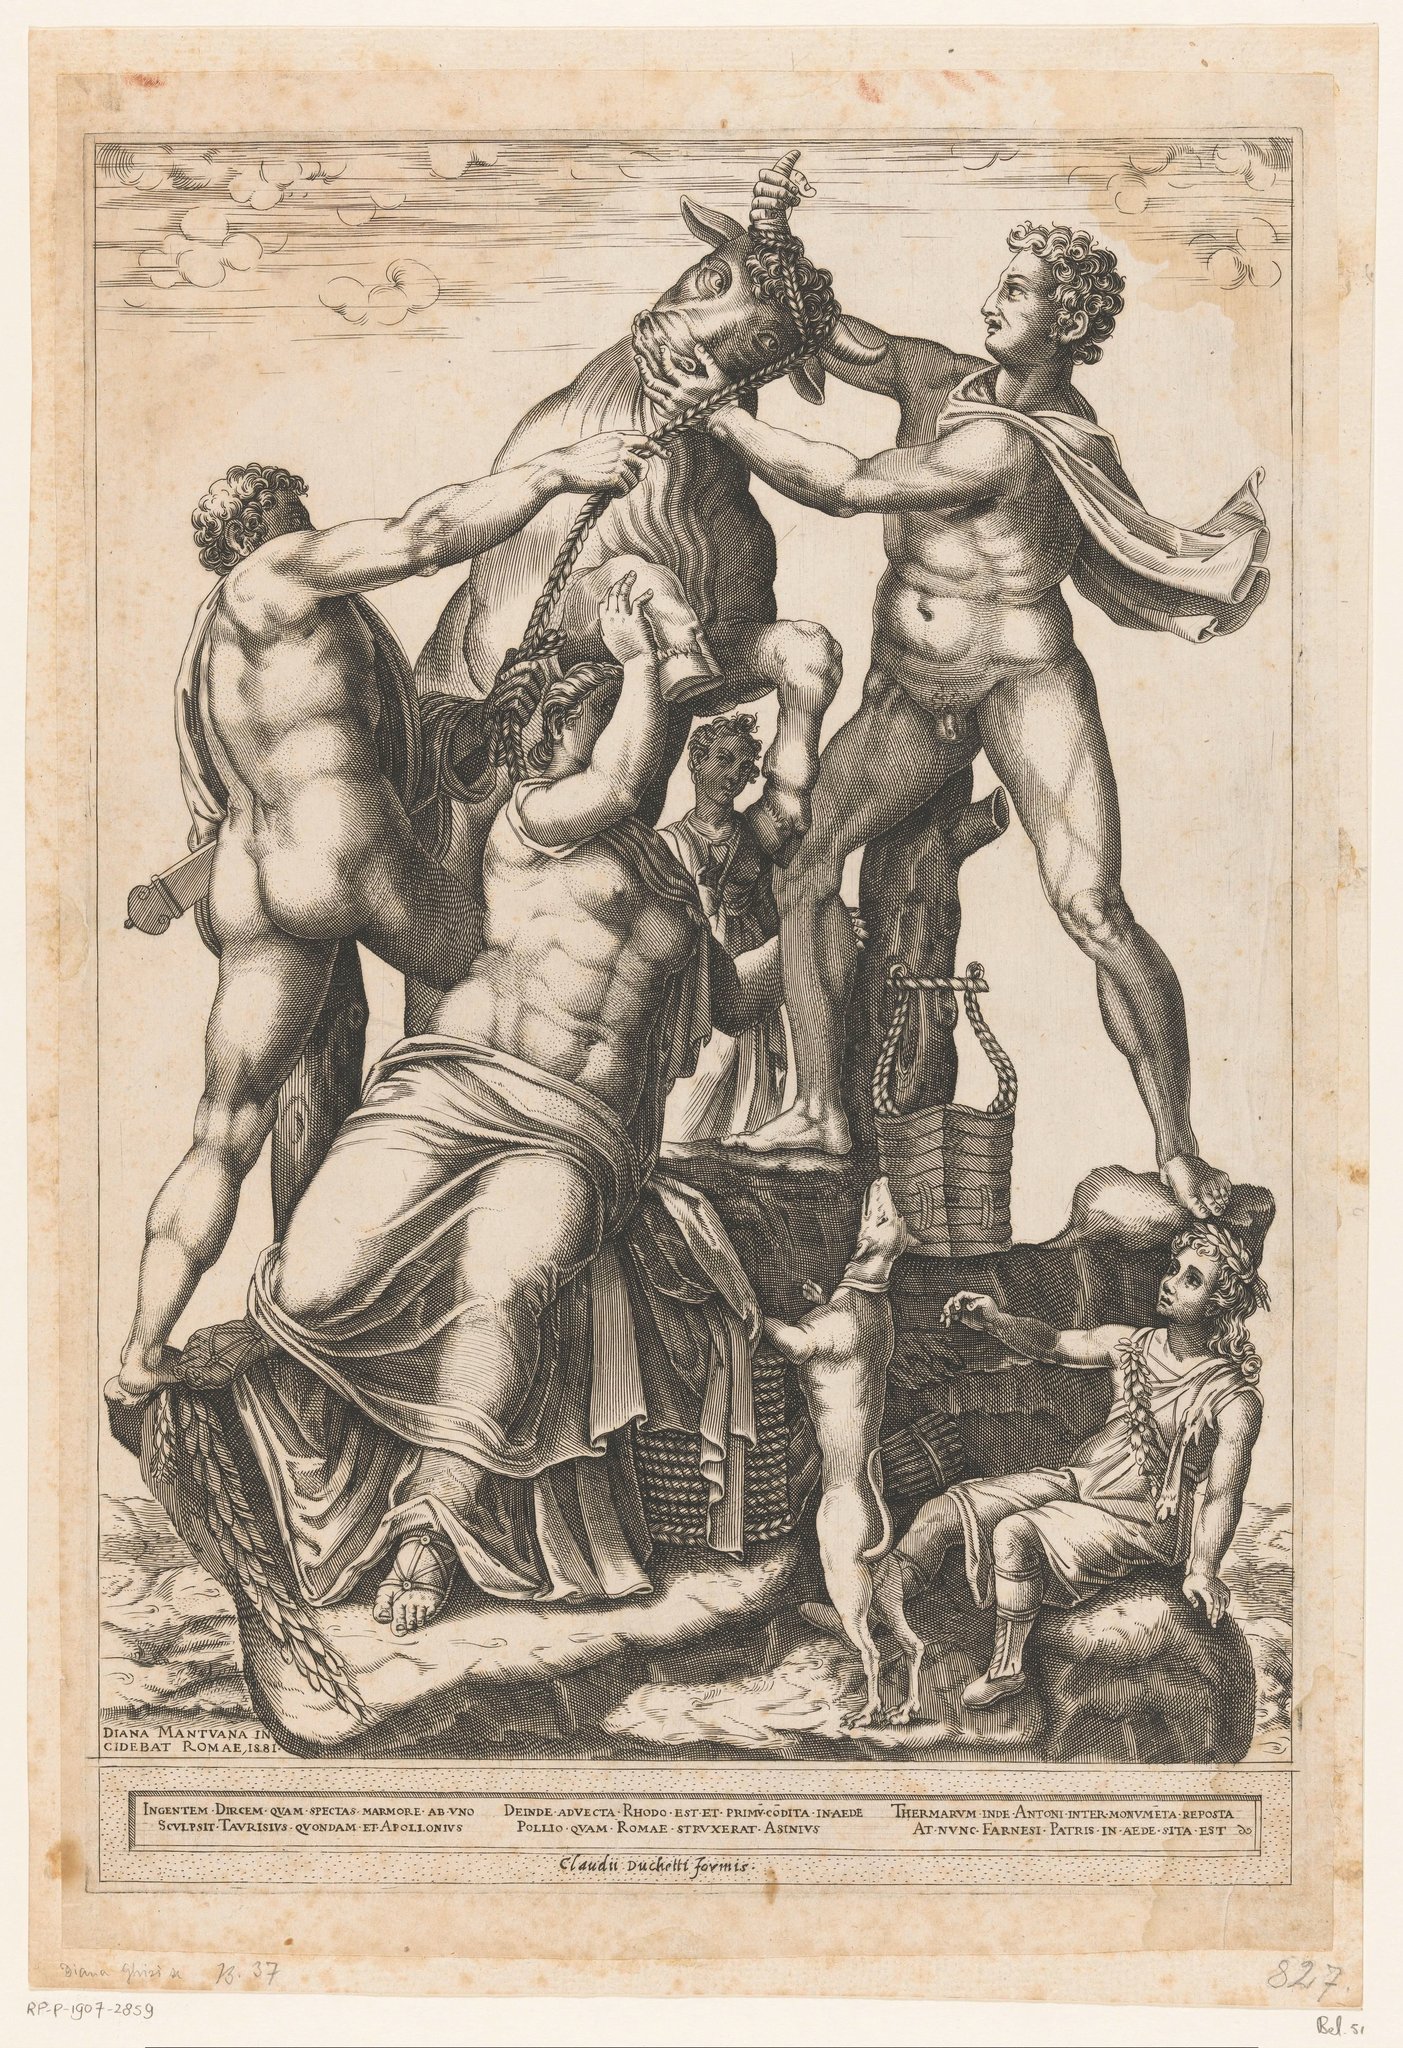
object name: print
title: Dirce wordt vastgebonden aan een stier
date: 1581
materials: paper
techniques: engraving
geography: rome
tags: slavery; serfs and enslaved persons, piece of sculpture, reproduction of a piece of sculpture, amphion and zethus avenge their mother by tying dirce to the horns of a bull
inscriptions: collector's mark: Lugt 2228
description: Antieke sculptuur bekend als de Farnese Stier. De broers Amphion en Zethus binden de gevlochten haren van Dirce vast aan de hoorns van een stier. Drie kolommen Latijnse tekst in de ondermarge.